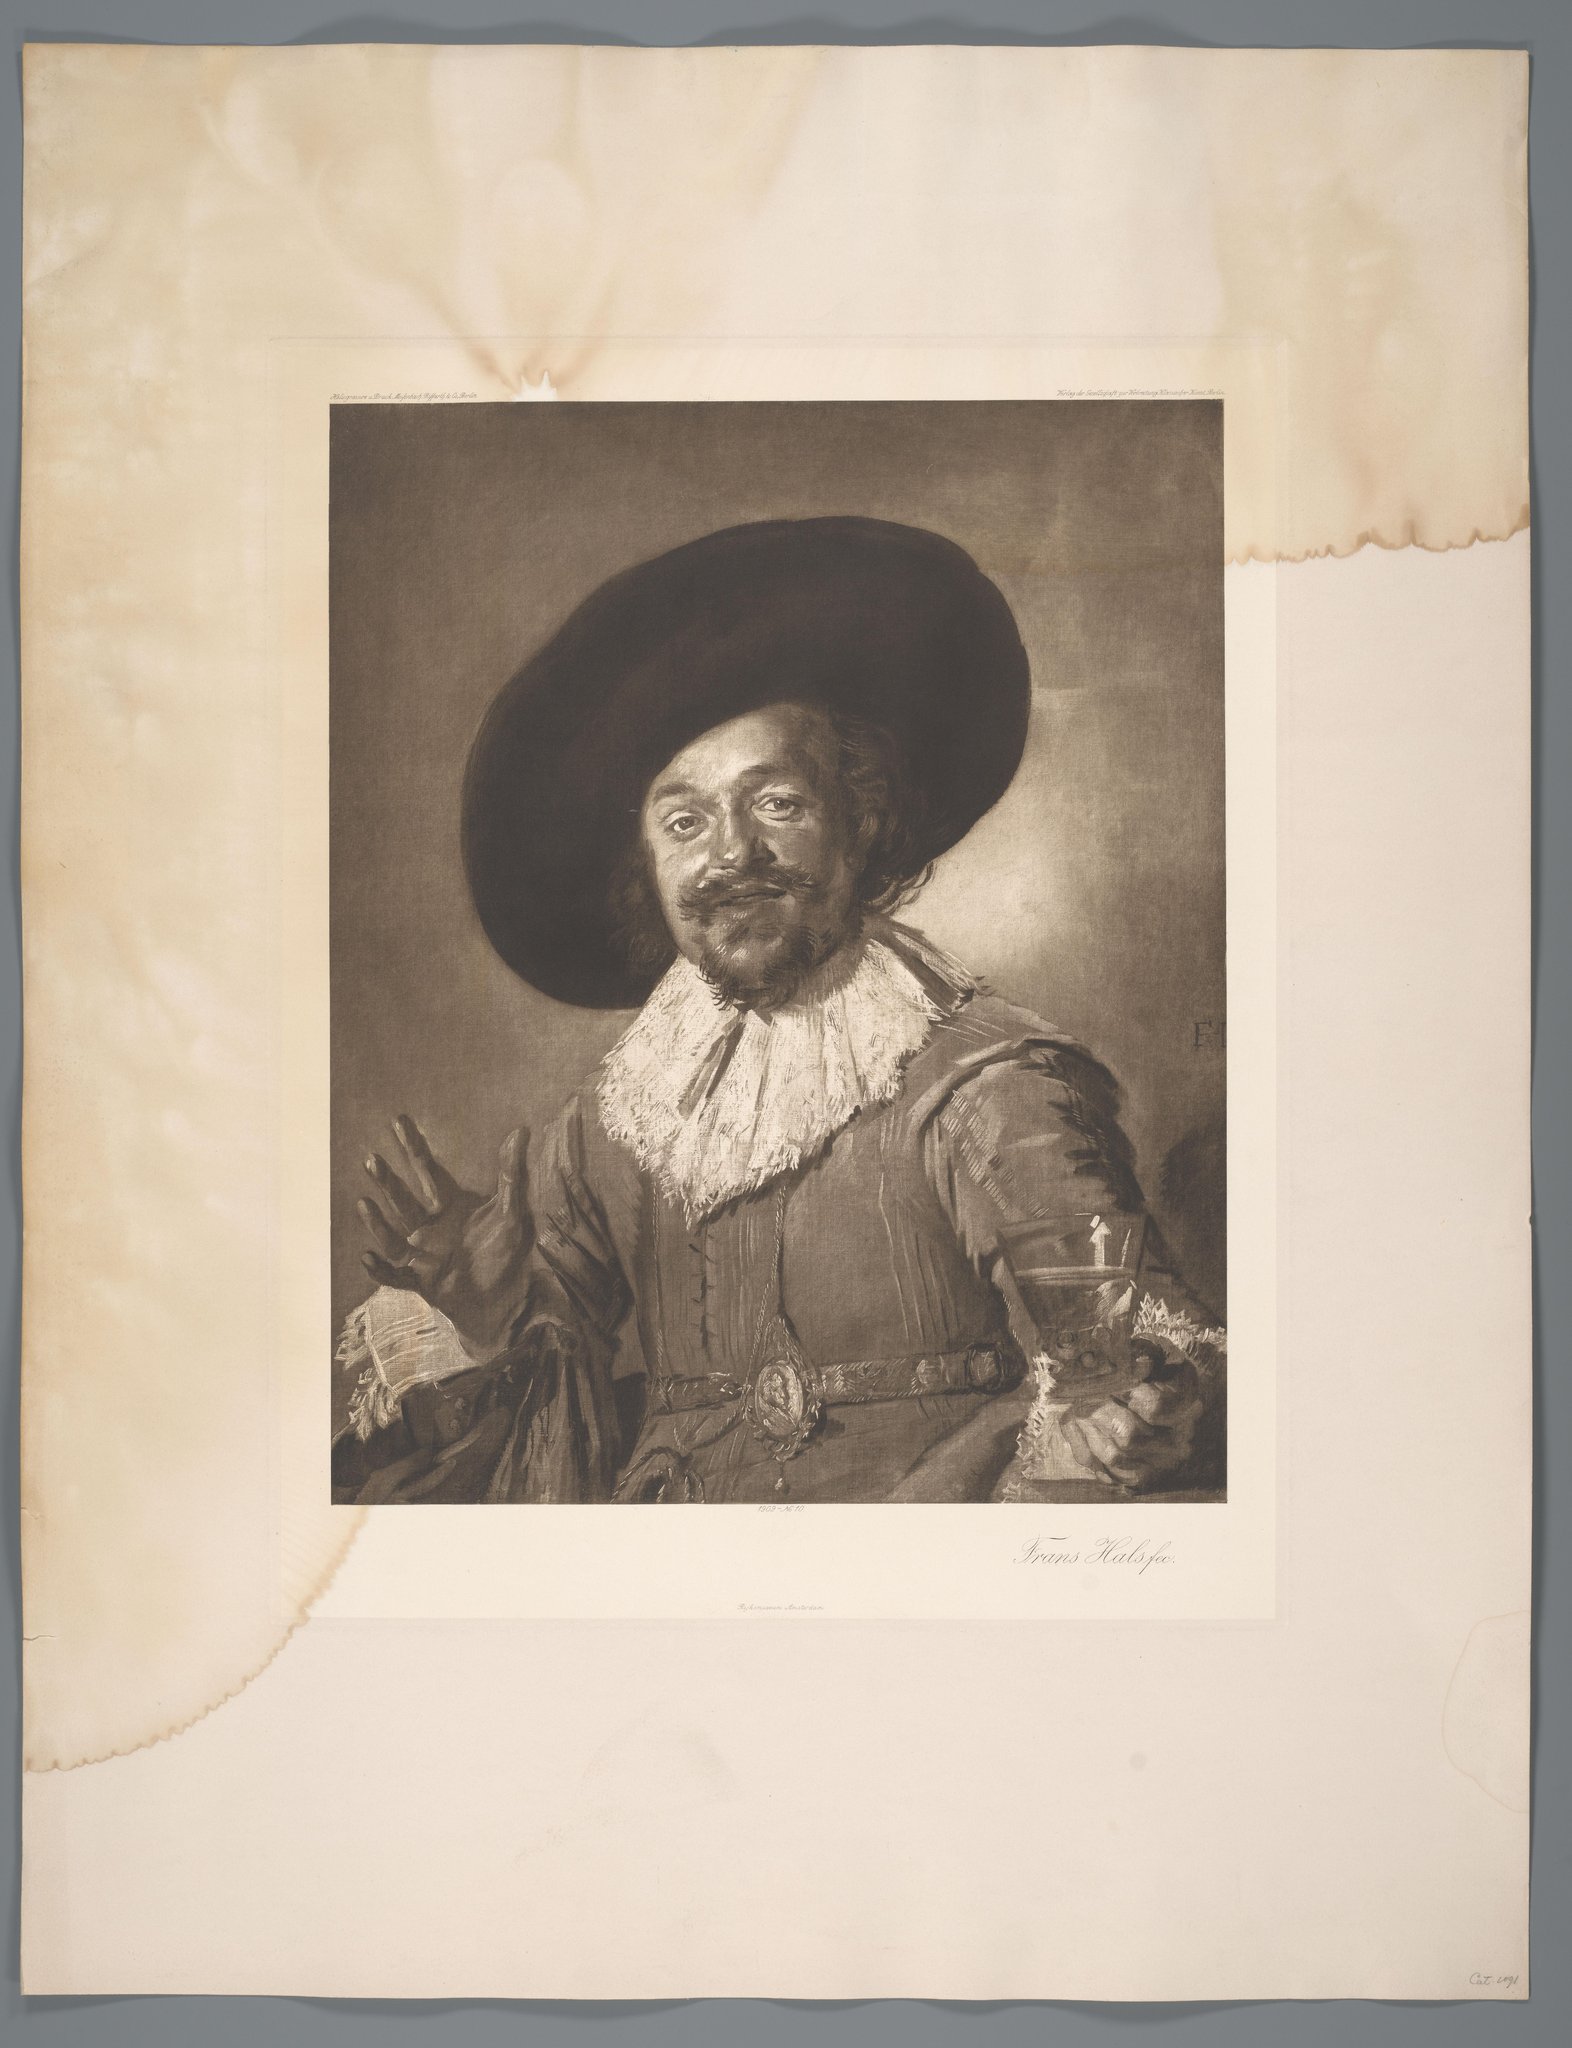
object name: photomechanical print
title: Reproductie van het schilderij Een schutter die een berkenmeier vasthoudt, bekend als ‘De vrolijke drinker’ door Frans Hals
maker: frans hals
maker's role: draughtsman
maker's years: 1582-1666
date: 1902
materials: cardboard, paper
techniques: photoaquatint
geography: berlin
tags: picture, painting, drinking